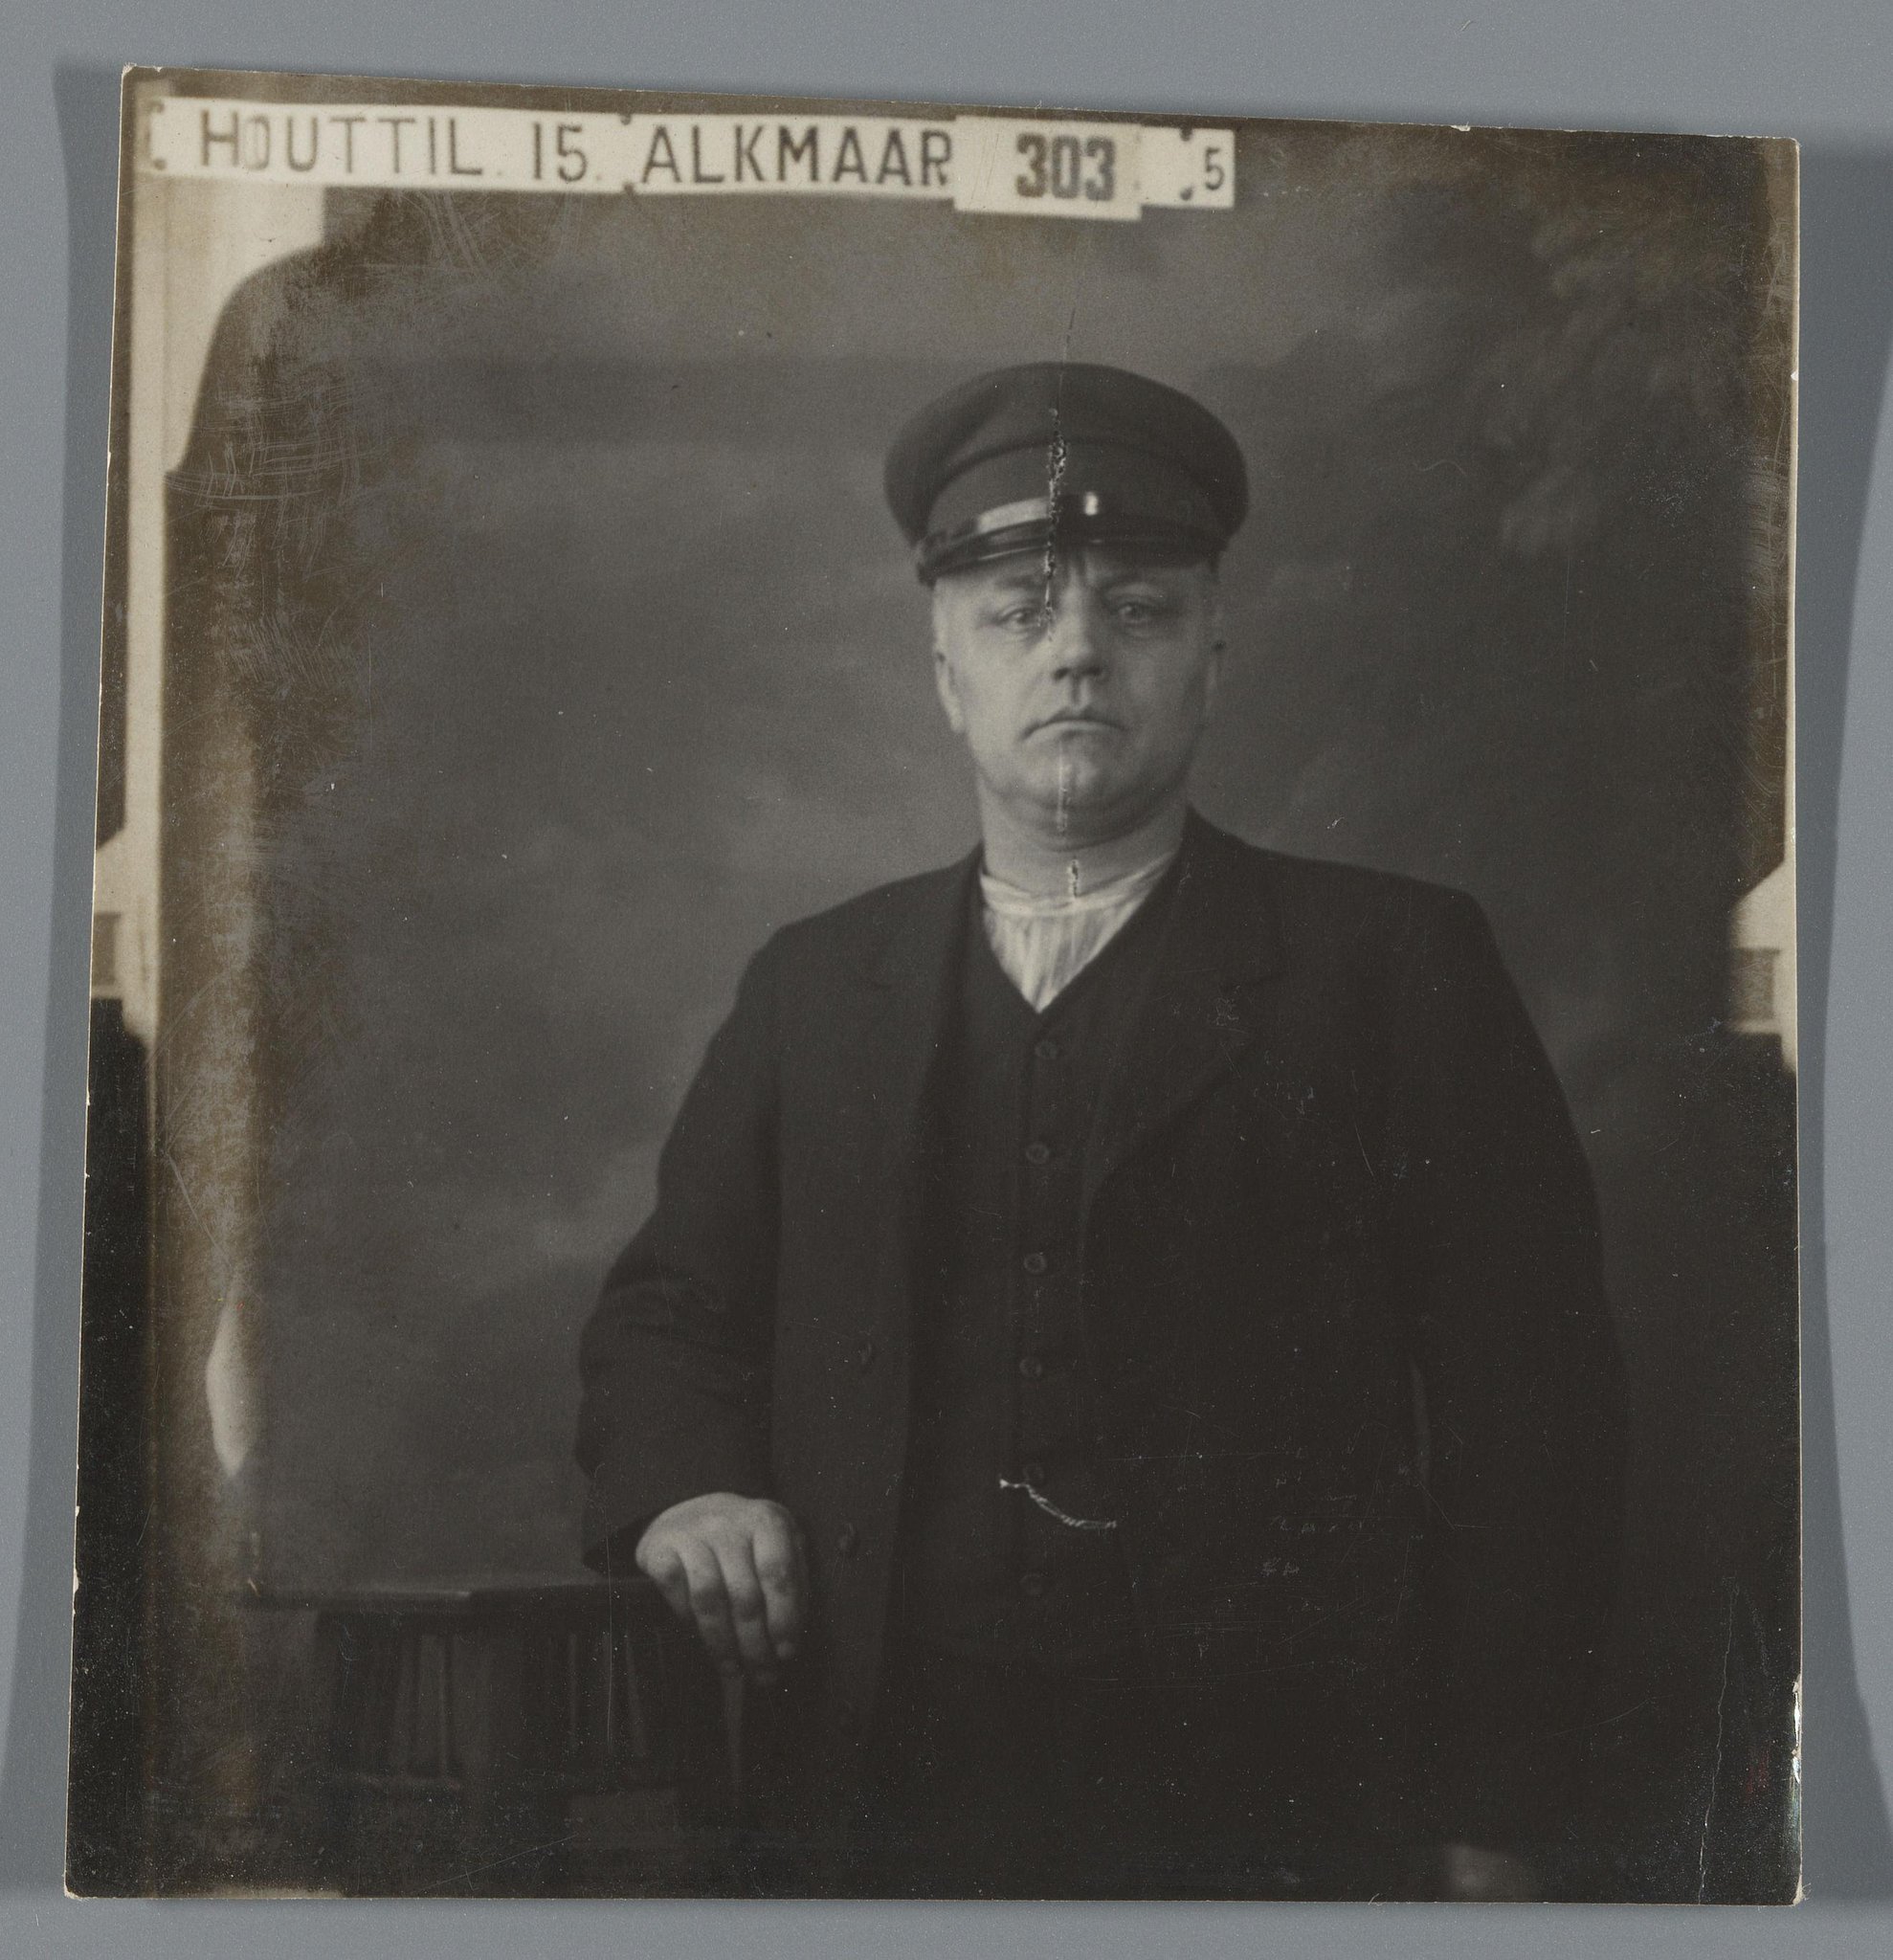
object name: snapshot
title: Portret van een onbekende man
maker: jan gottfried stütner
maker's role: fotograaf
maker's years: 1892-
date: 1913-1926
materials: photographic support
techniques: gelatin silver print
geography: alkmaar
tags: alkmaar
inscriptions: inscription: ‘HOUTTIL 15 ALKMAAR Nr. 303’